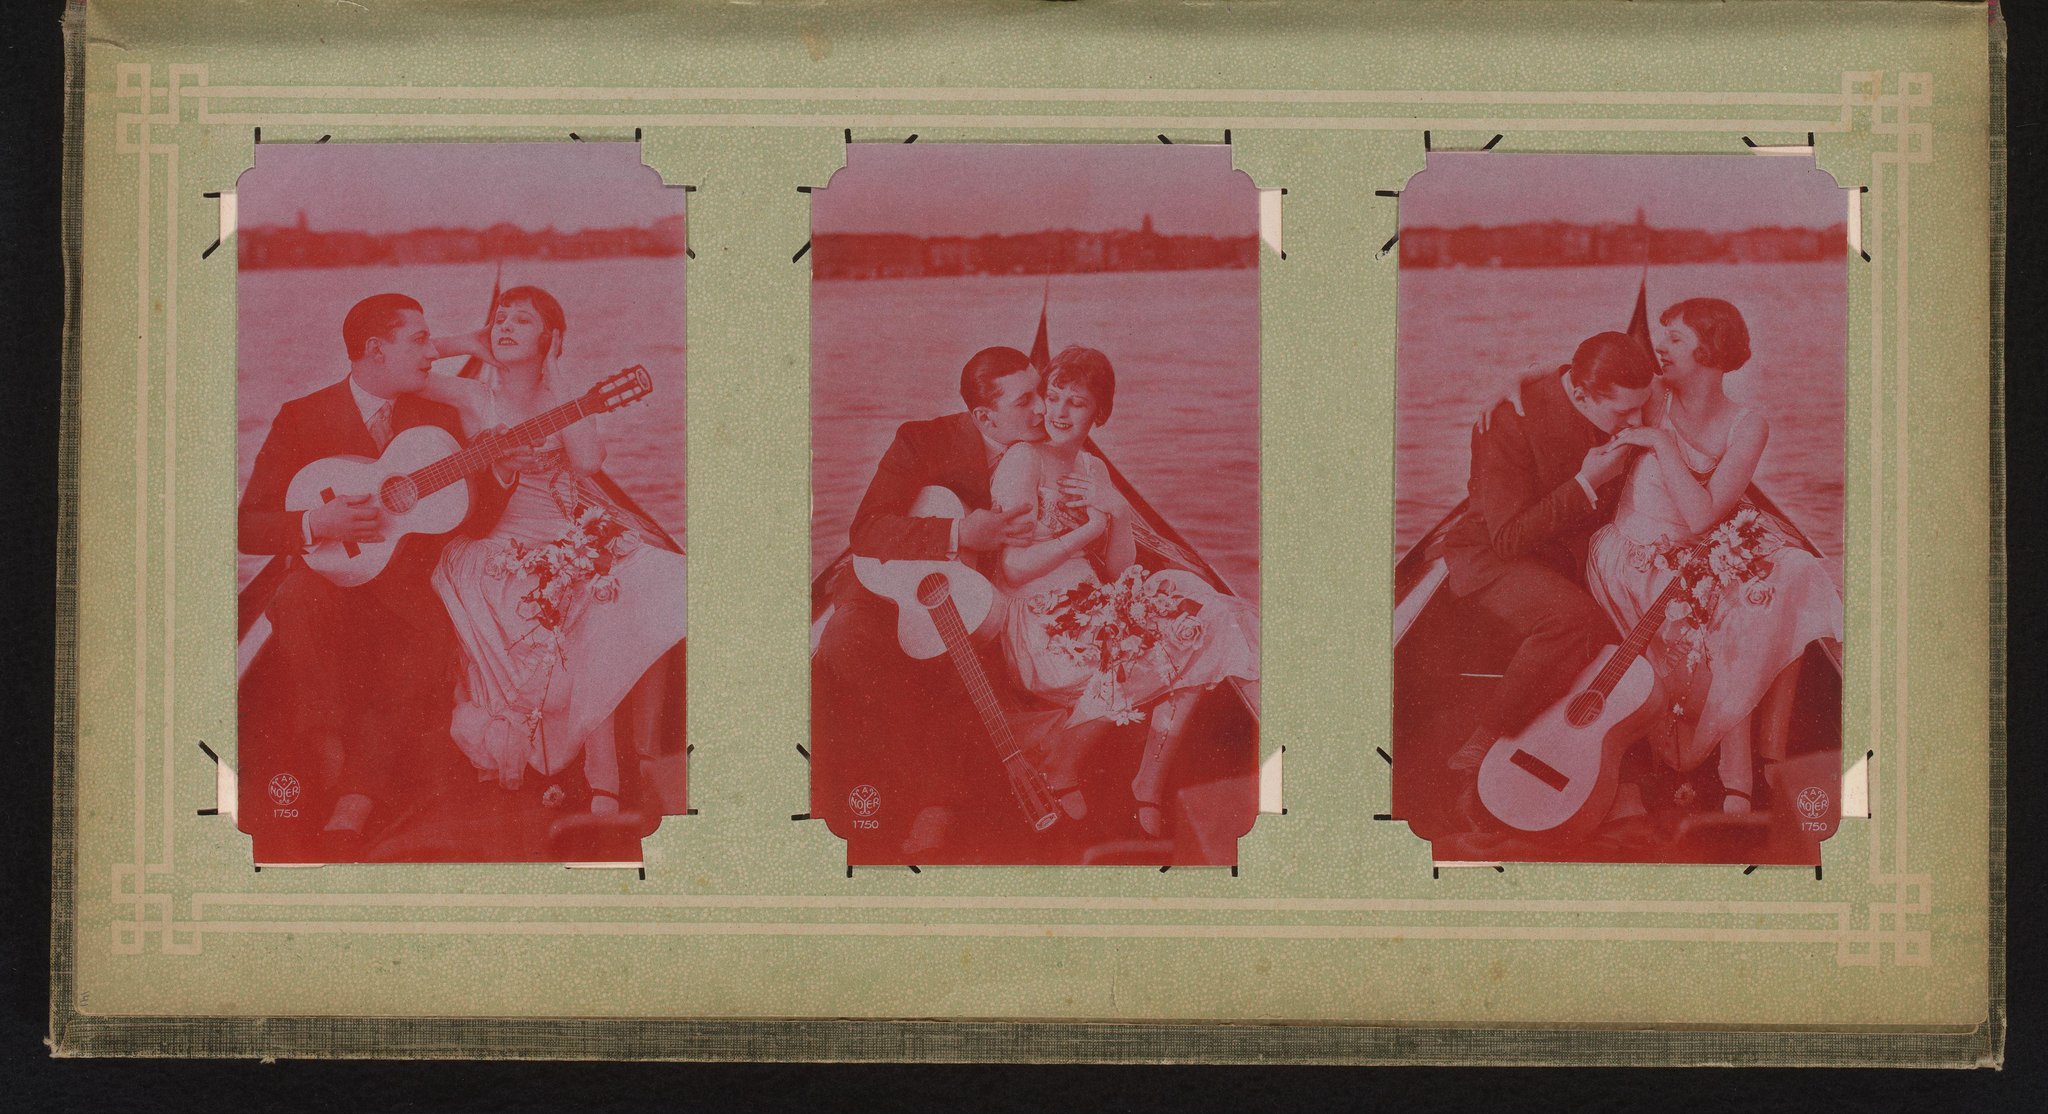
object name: album leaf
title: Drie portretten van een paar geliefden met een gitaar in een roeiboot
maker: alfred noyer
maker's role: publisher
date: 1900-1930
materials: cardboard, photographic support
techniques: gelatin silver print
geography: paris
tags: rowing-boat, canoe, etc., cithern, mandolin, guitar, balalaika, couple of lovers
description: Deze foto's maken deel uit van een album.